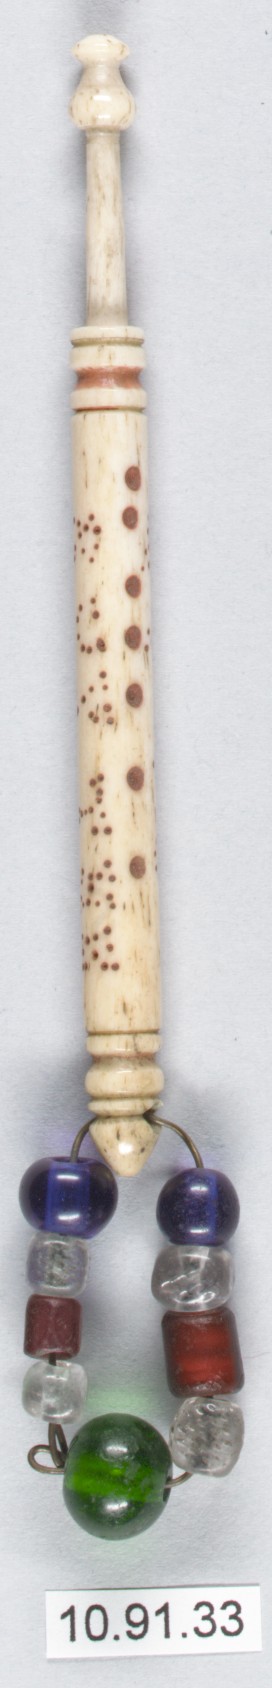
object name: bobbin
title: Old English bone bobbin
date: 1801-1900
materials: bone